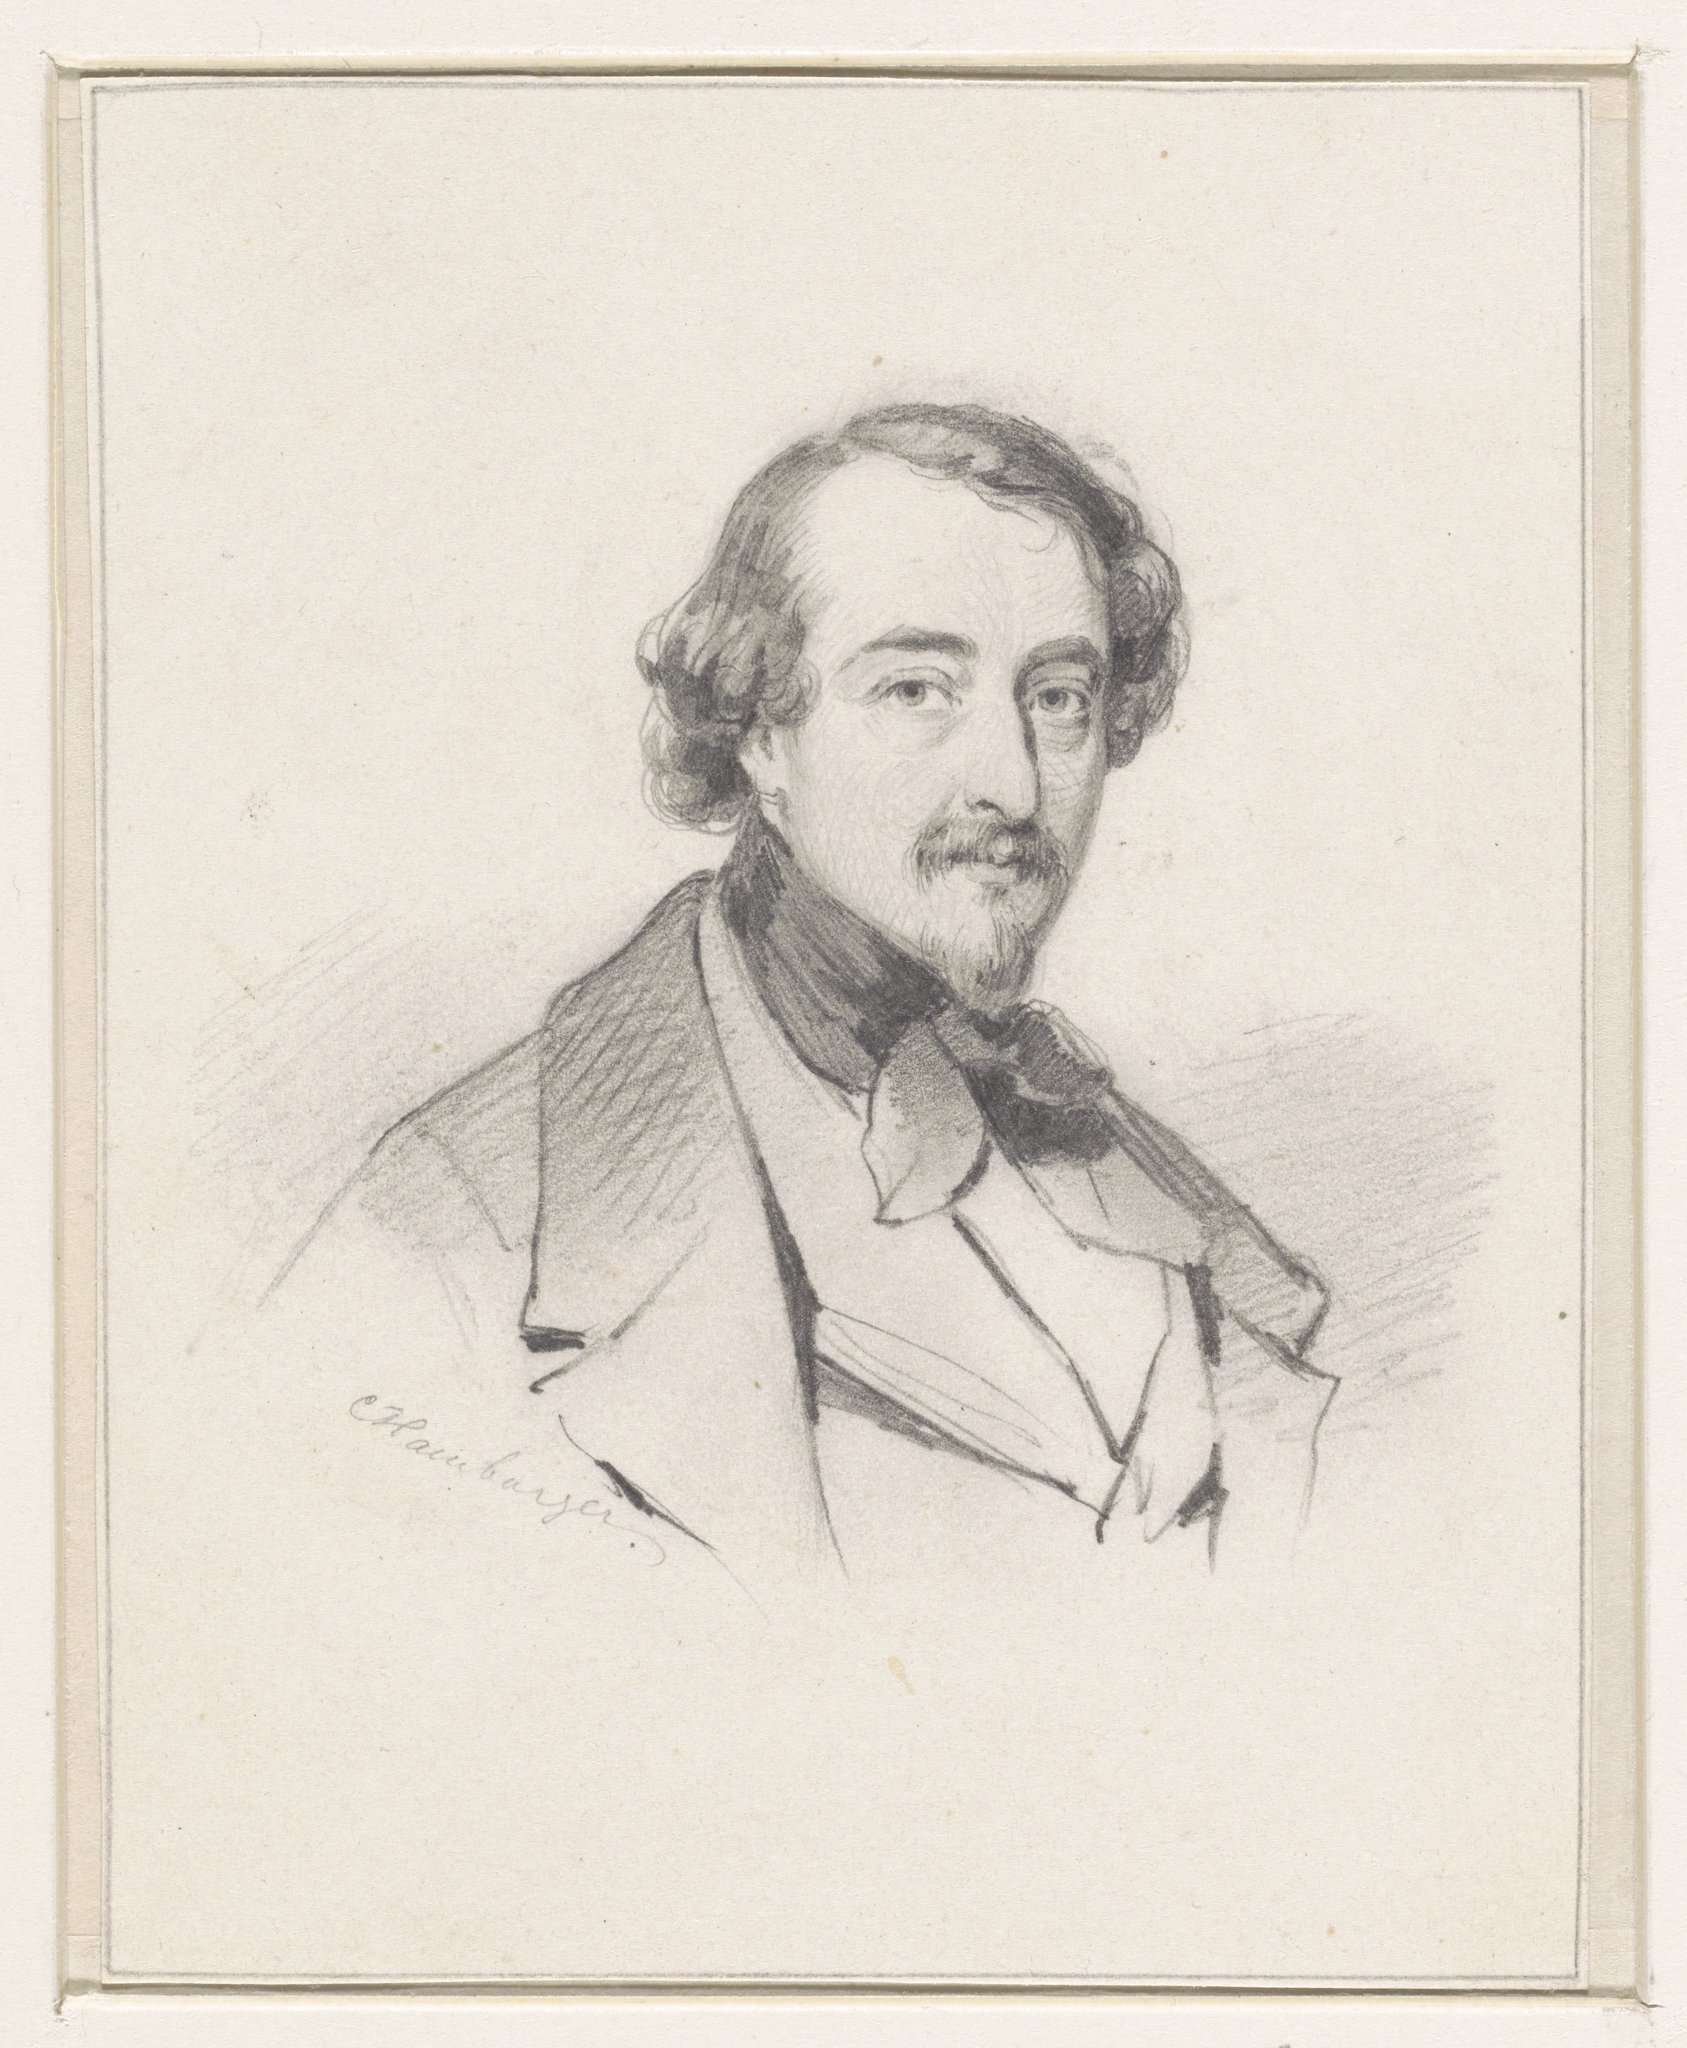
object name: drawing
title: Portret van Christiaan Immerzeel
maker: coenraad hamburger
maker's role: draughtsman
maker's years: 1809-1891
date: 1841-1842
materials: paper, pencil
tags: the hague, print maker, christiaan immerzeel, historical persons, portrait, self-portrait of painter, portrait, self-portrait of artist, portrait, self-portrait of draughtsman